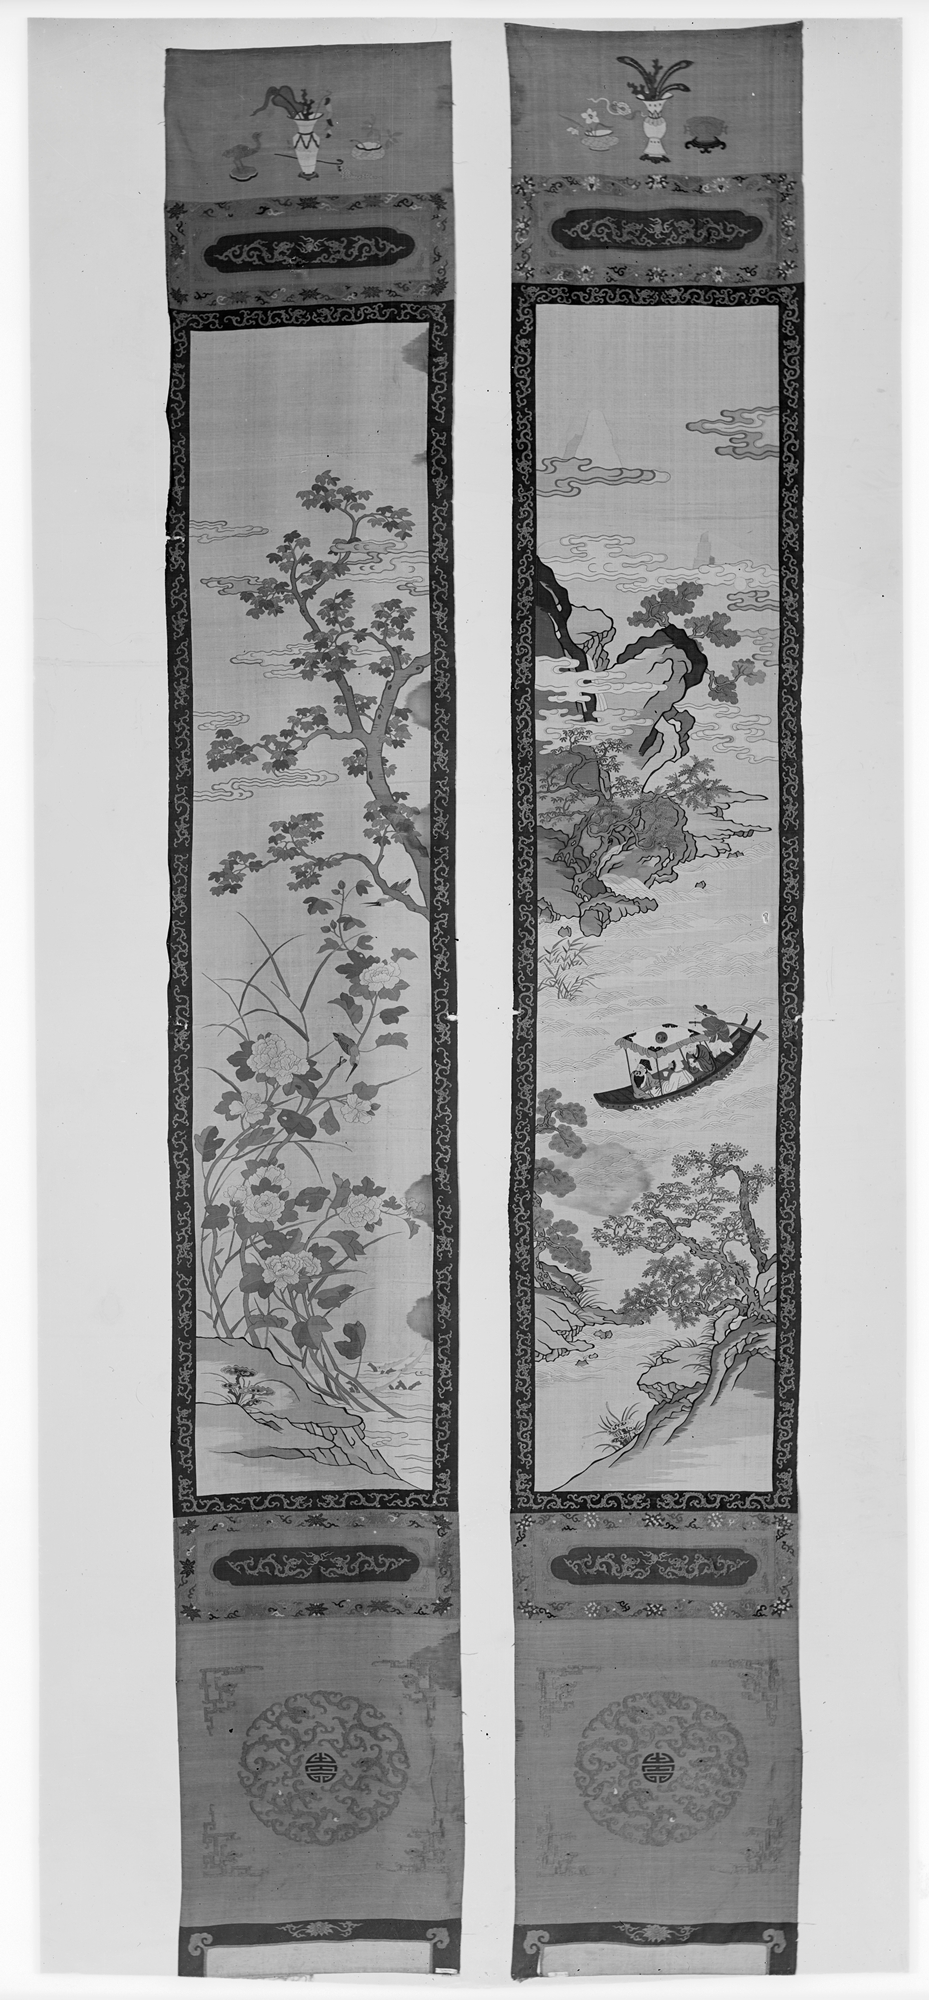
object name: picture, tapestry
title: Tapestry Picture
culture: chinese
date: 1767-1833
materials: metal thread, silk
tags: trees,boats